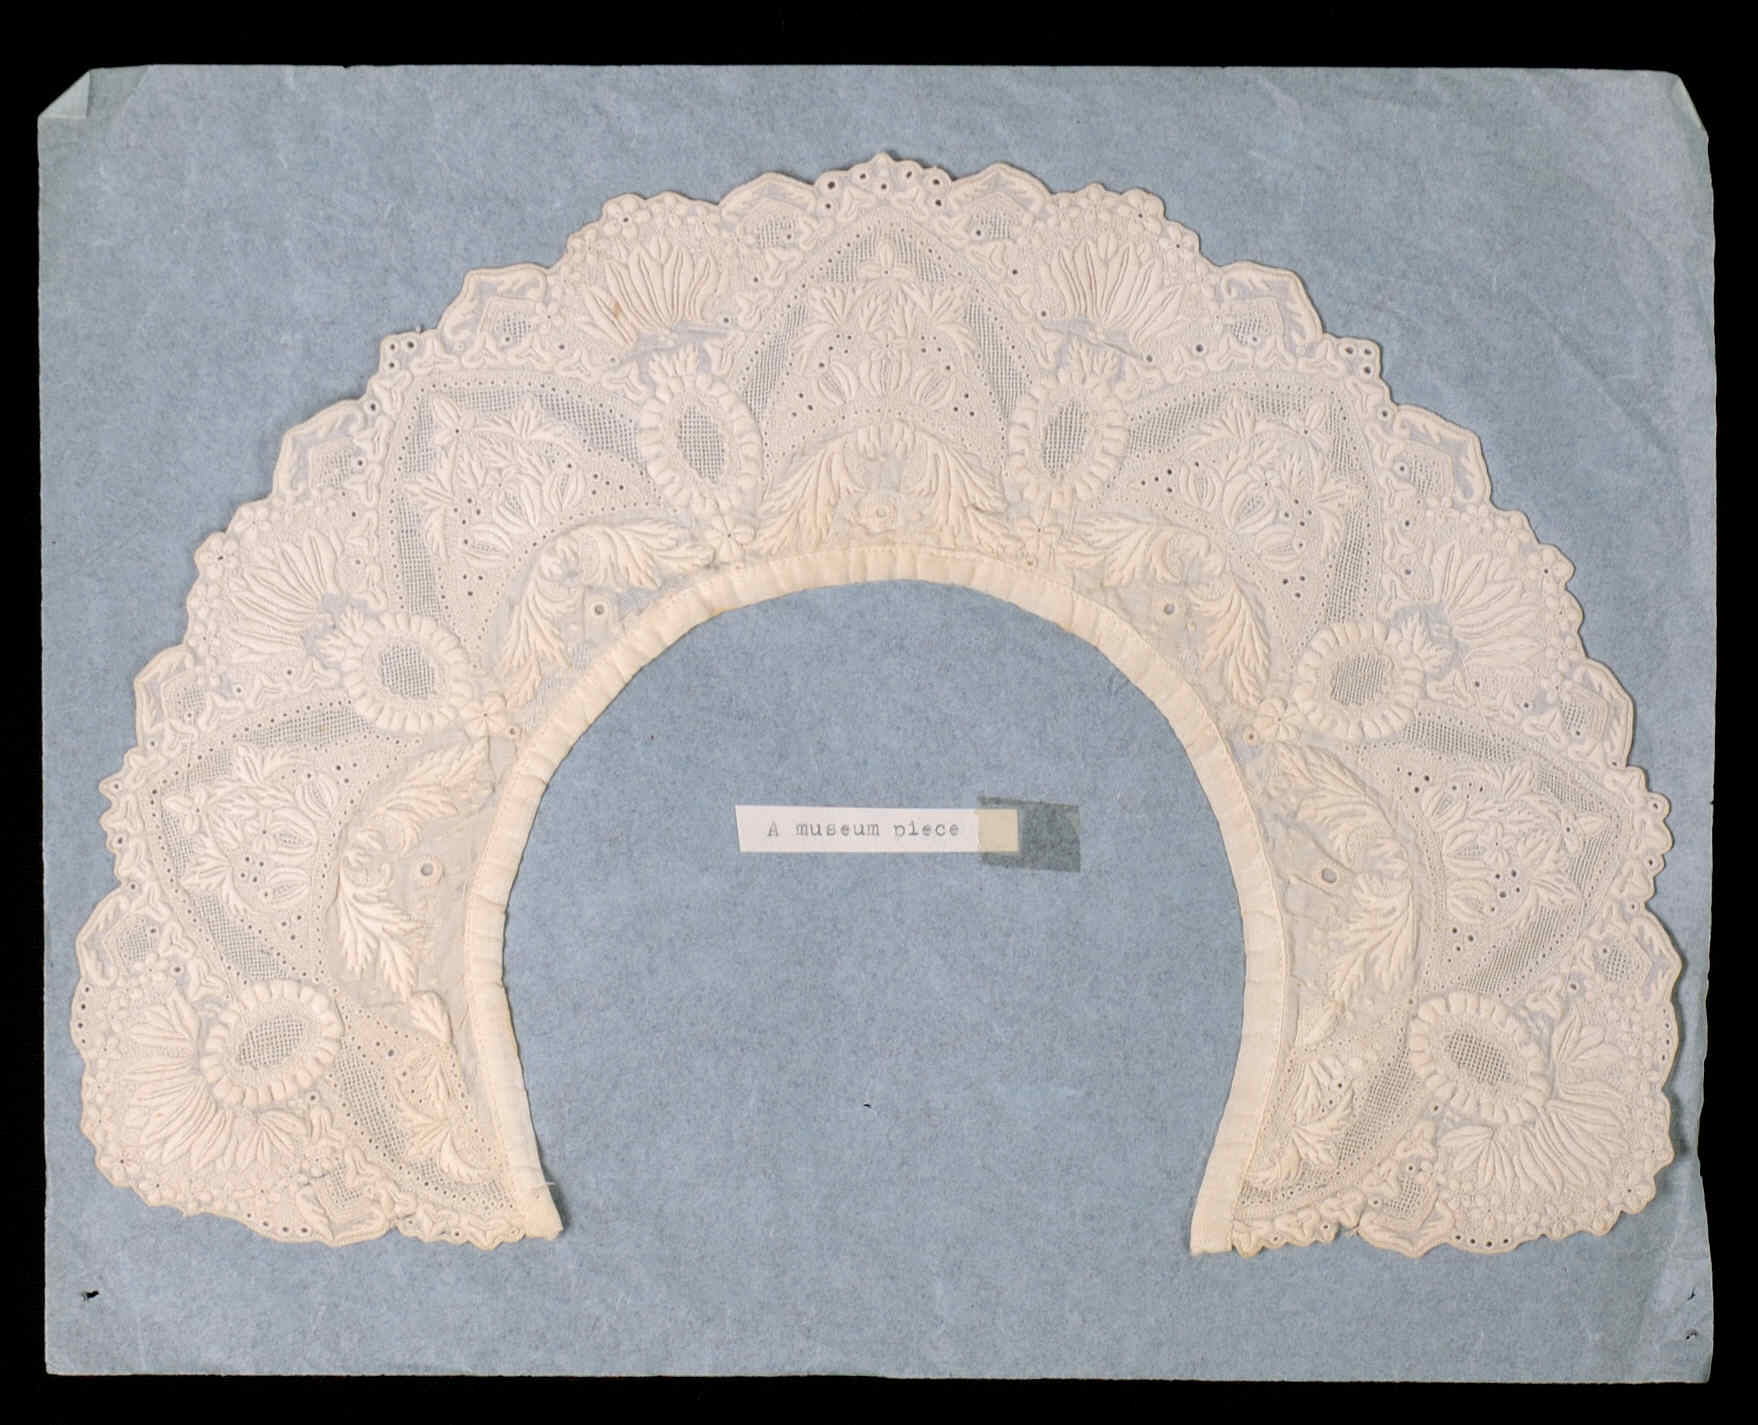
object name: collar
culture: american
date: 1834-1866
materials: cotton